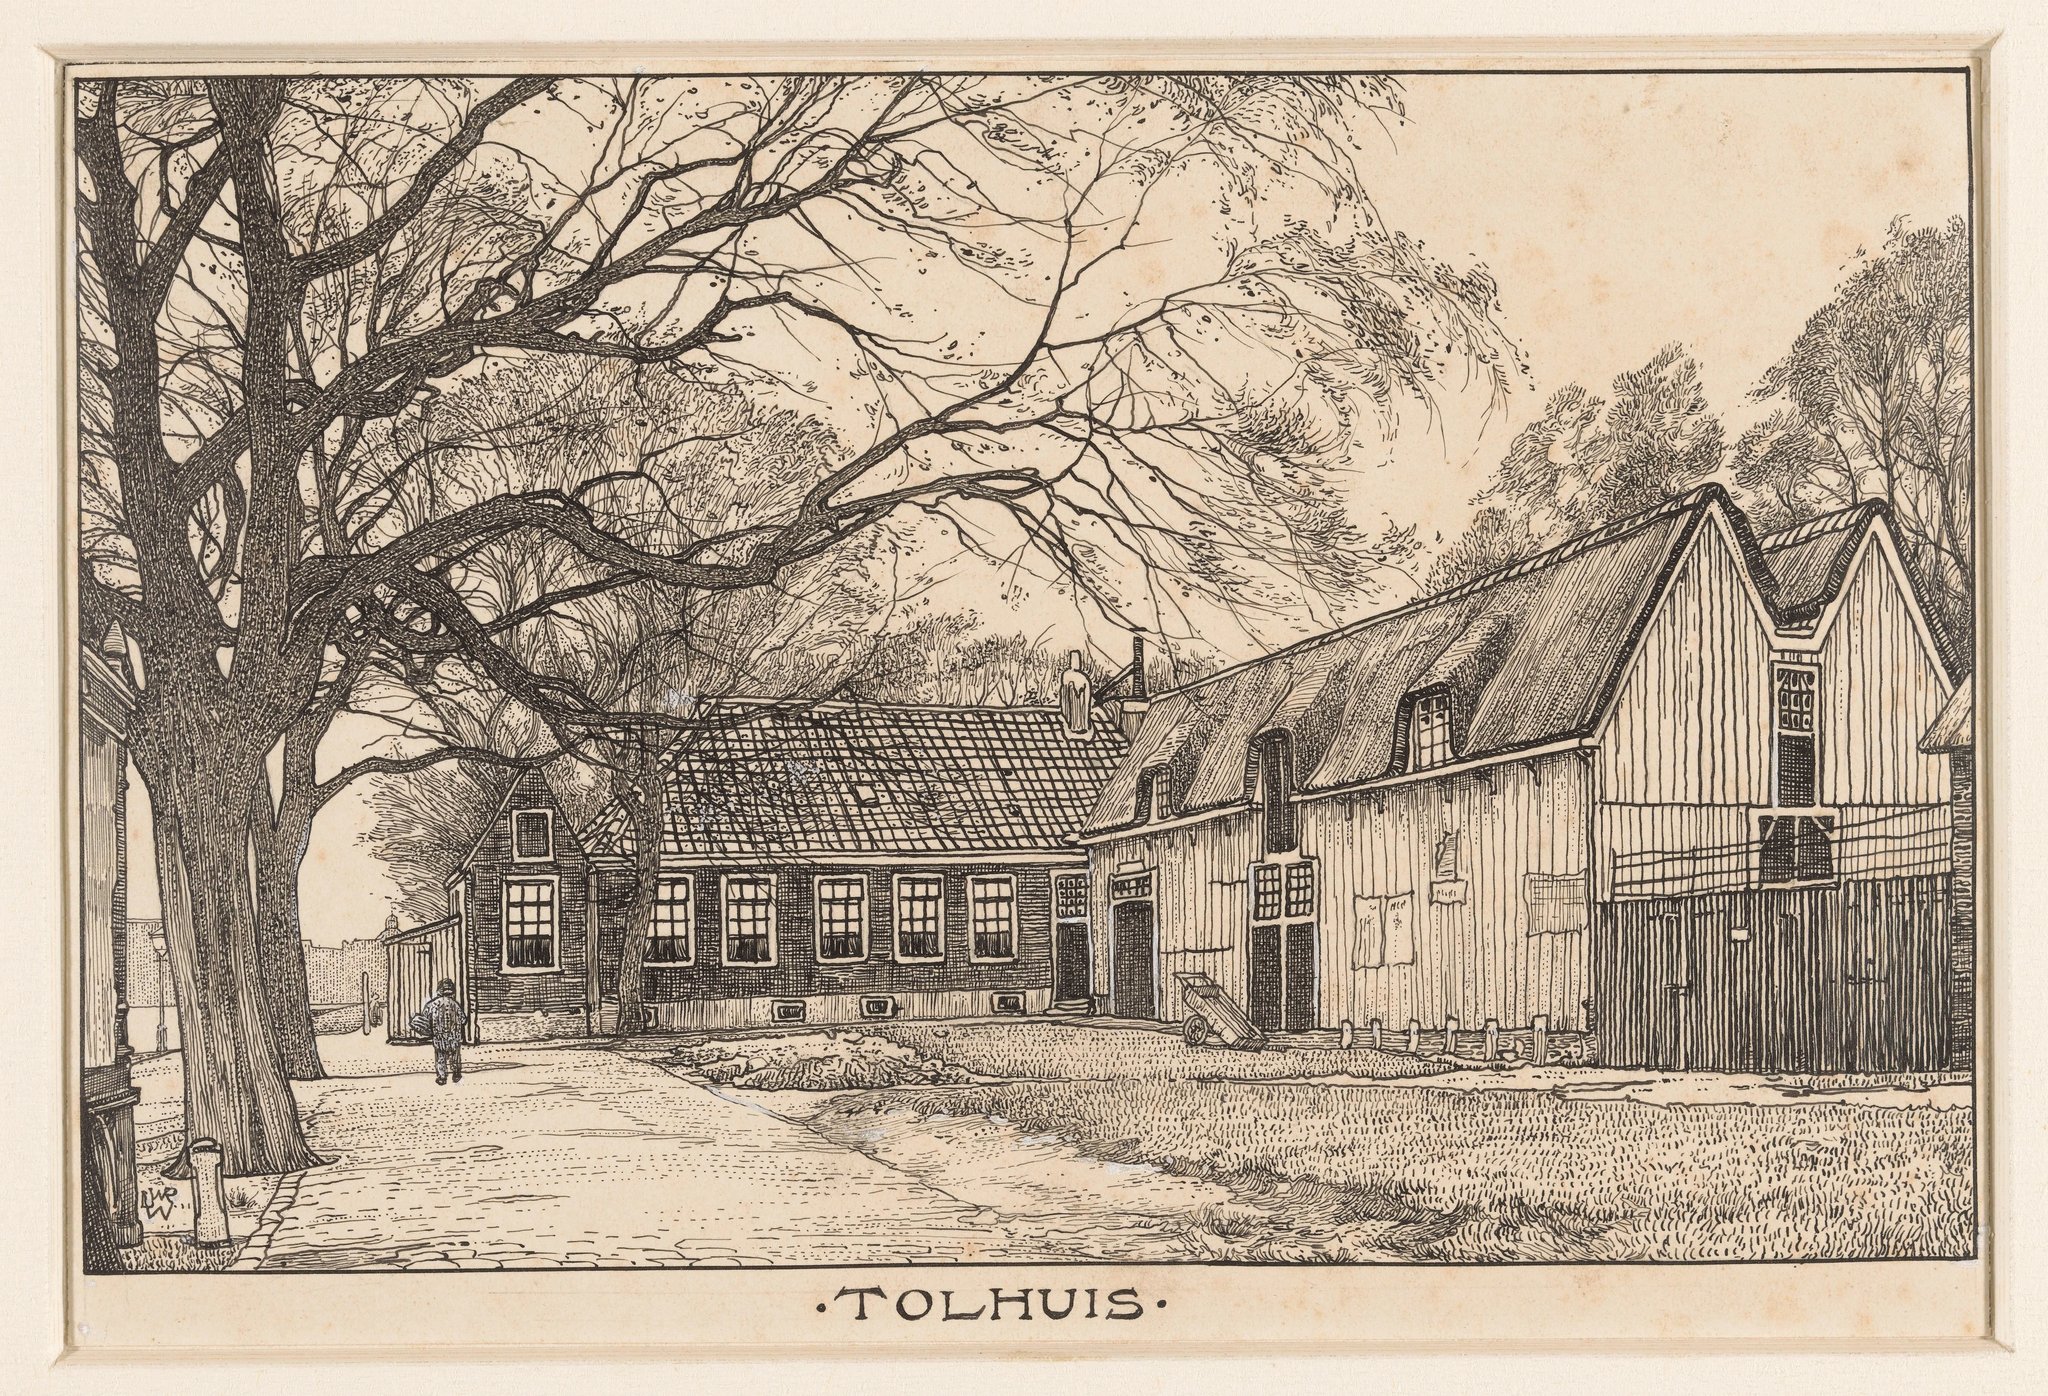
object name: drawing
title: Het Tolhuis aan de Buiksloterweg te Amsterdam (overzijde van het IJ)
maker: willem wenckebach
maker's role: designer, draughtsman, painter, print maker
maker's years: 1860-1937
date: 1870-1926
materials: paint, ink, paper, pencil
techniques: pen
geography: amsterdam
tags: tolhuis, buiksloterweg